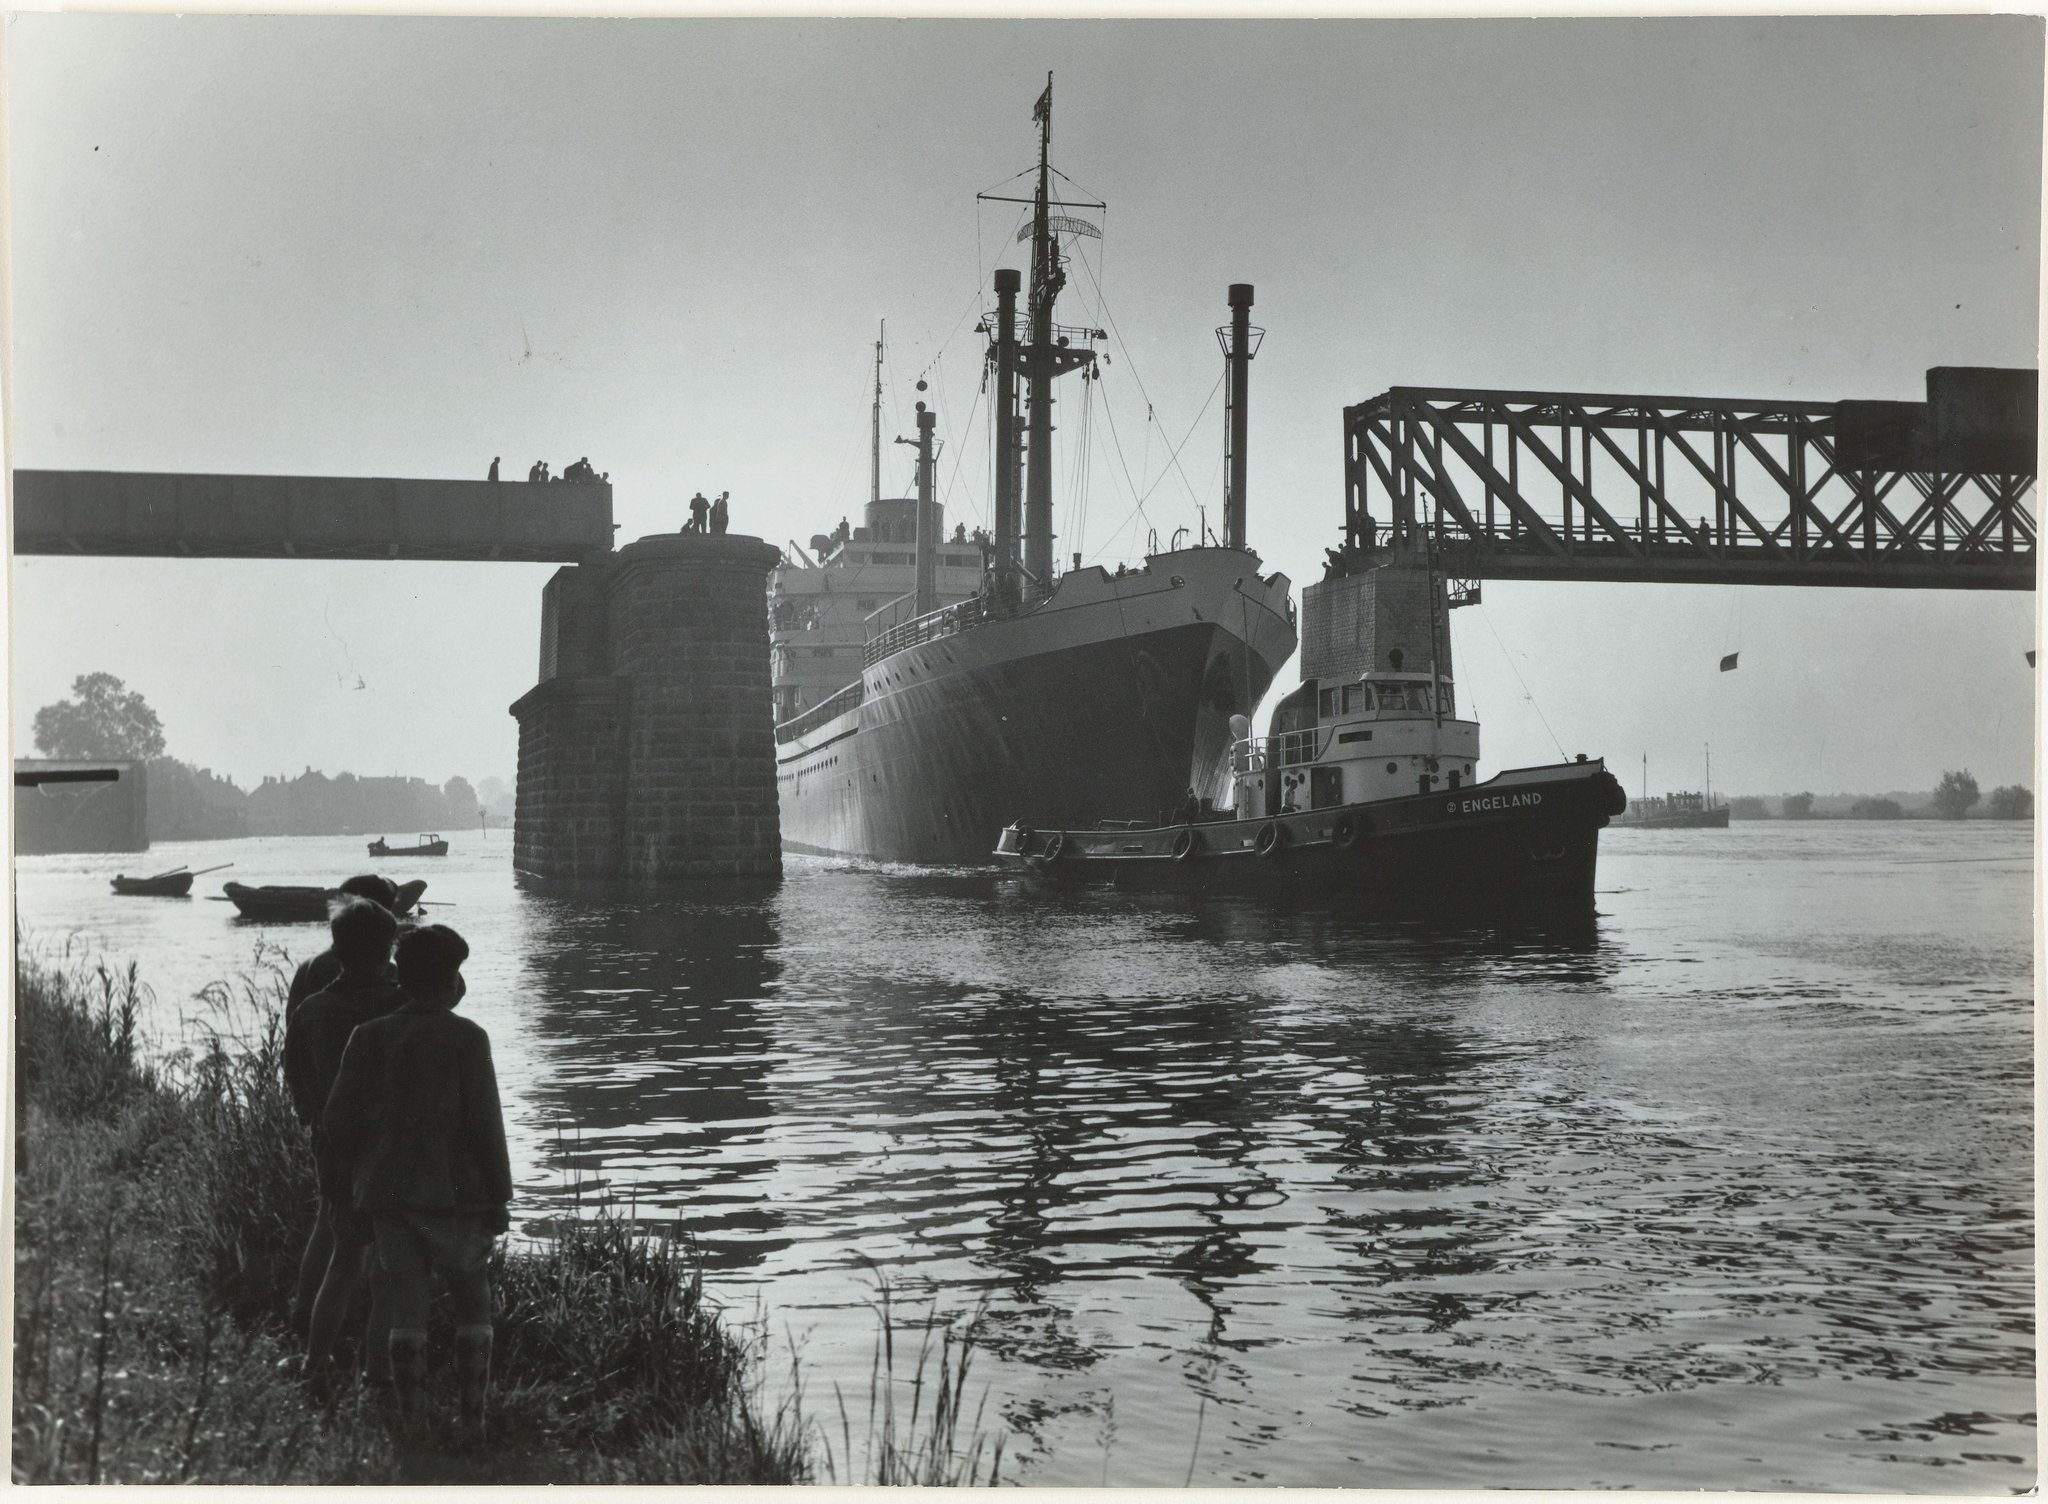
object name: photograph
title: Schip vaart door open brug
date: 1950-1960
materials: photographic support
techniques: photography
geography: netherlands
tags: netherlands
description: Een vrachtschip wordt door een onttakelde brug gesleept door de sleepboot 'Engeland'; langs de kant staan mensen te kijken.